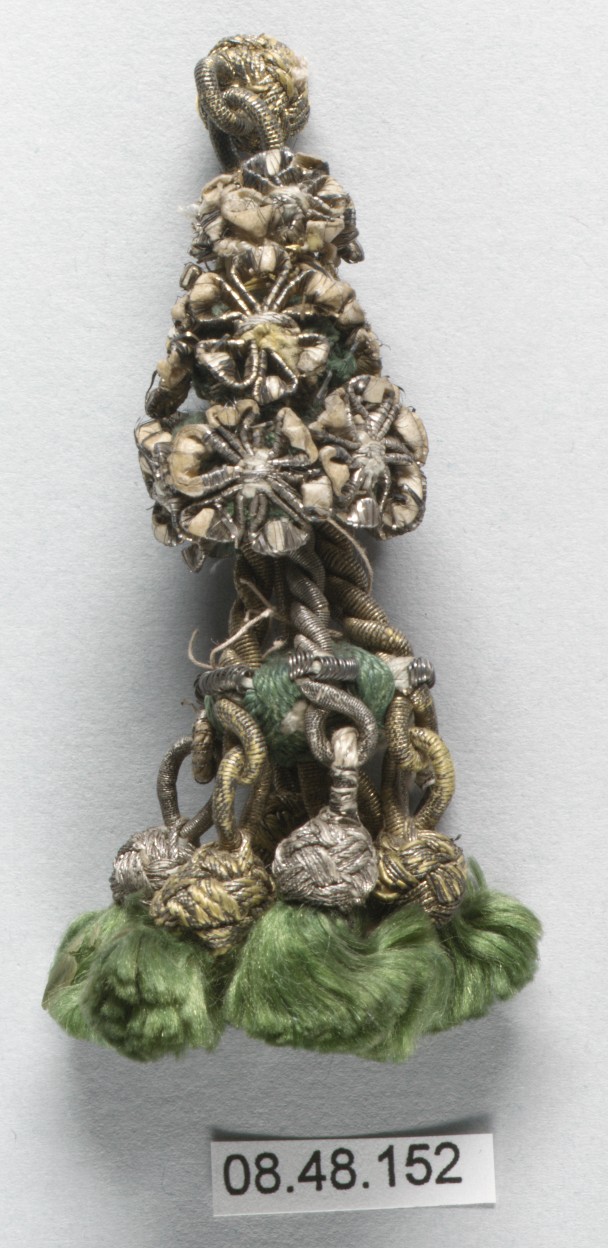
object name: tassel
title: Tassels (3)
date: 1701-1800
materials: metal thread, silk